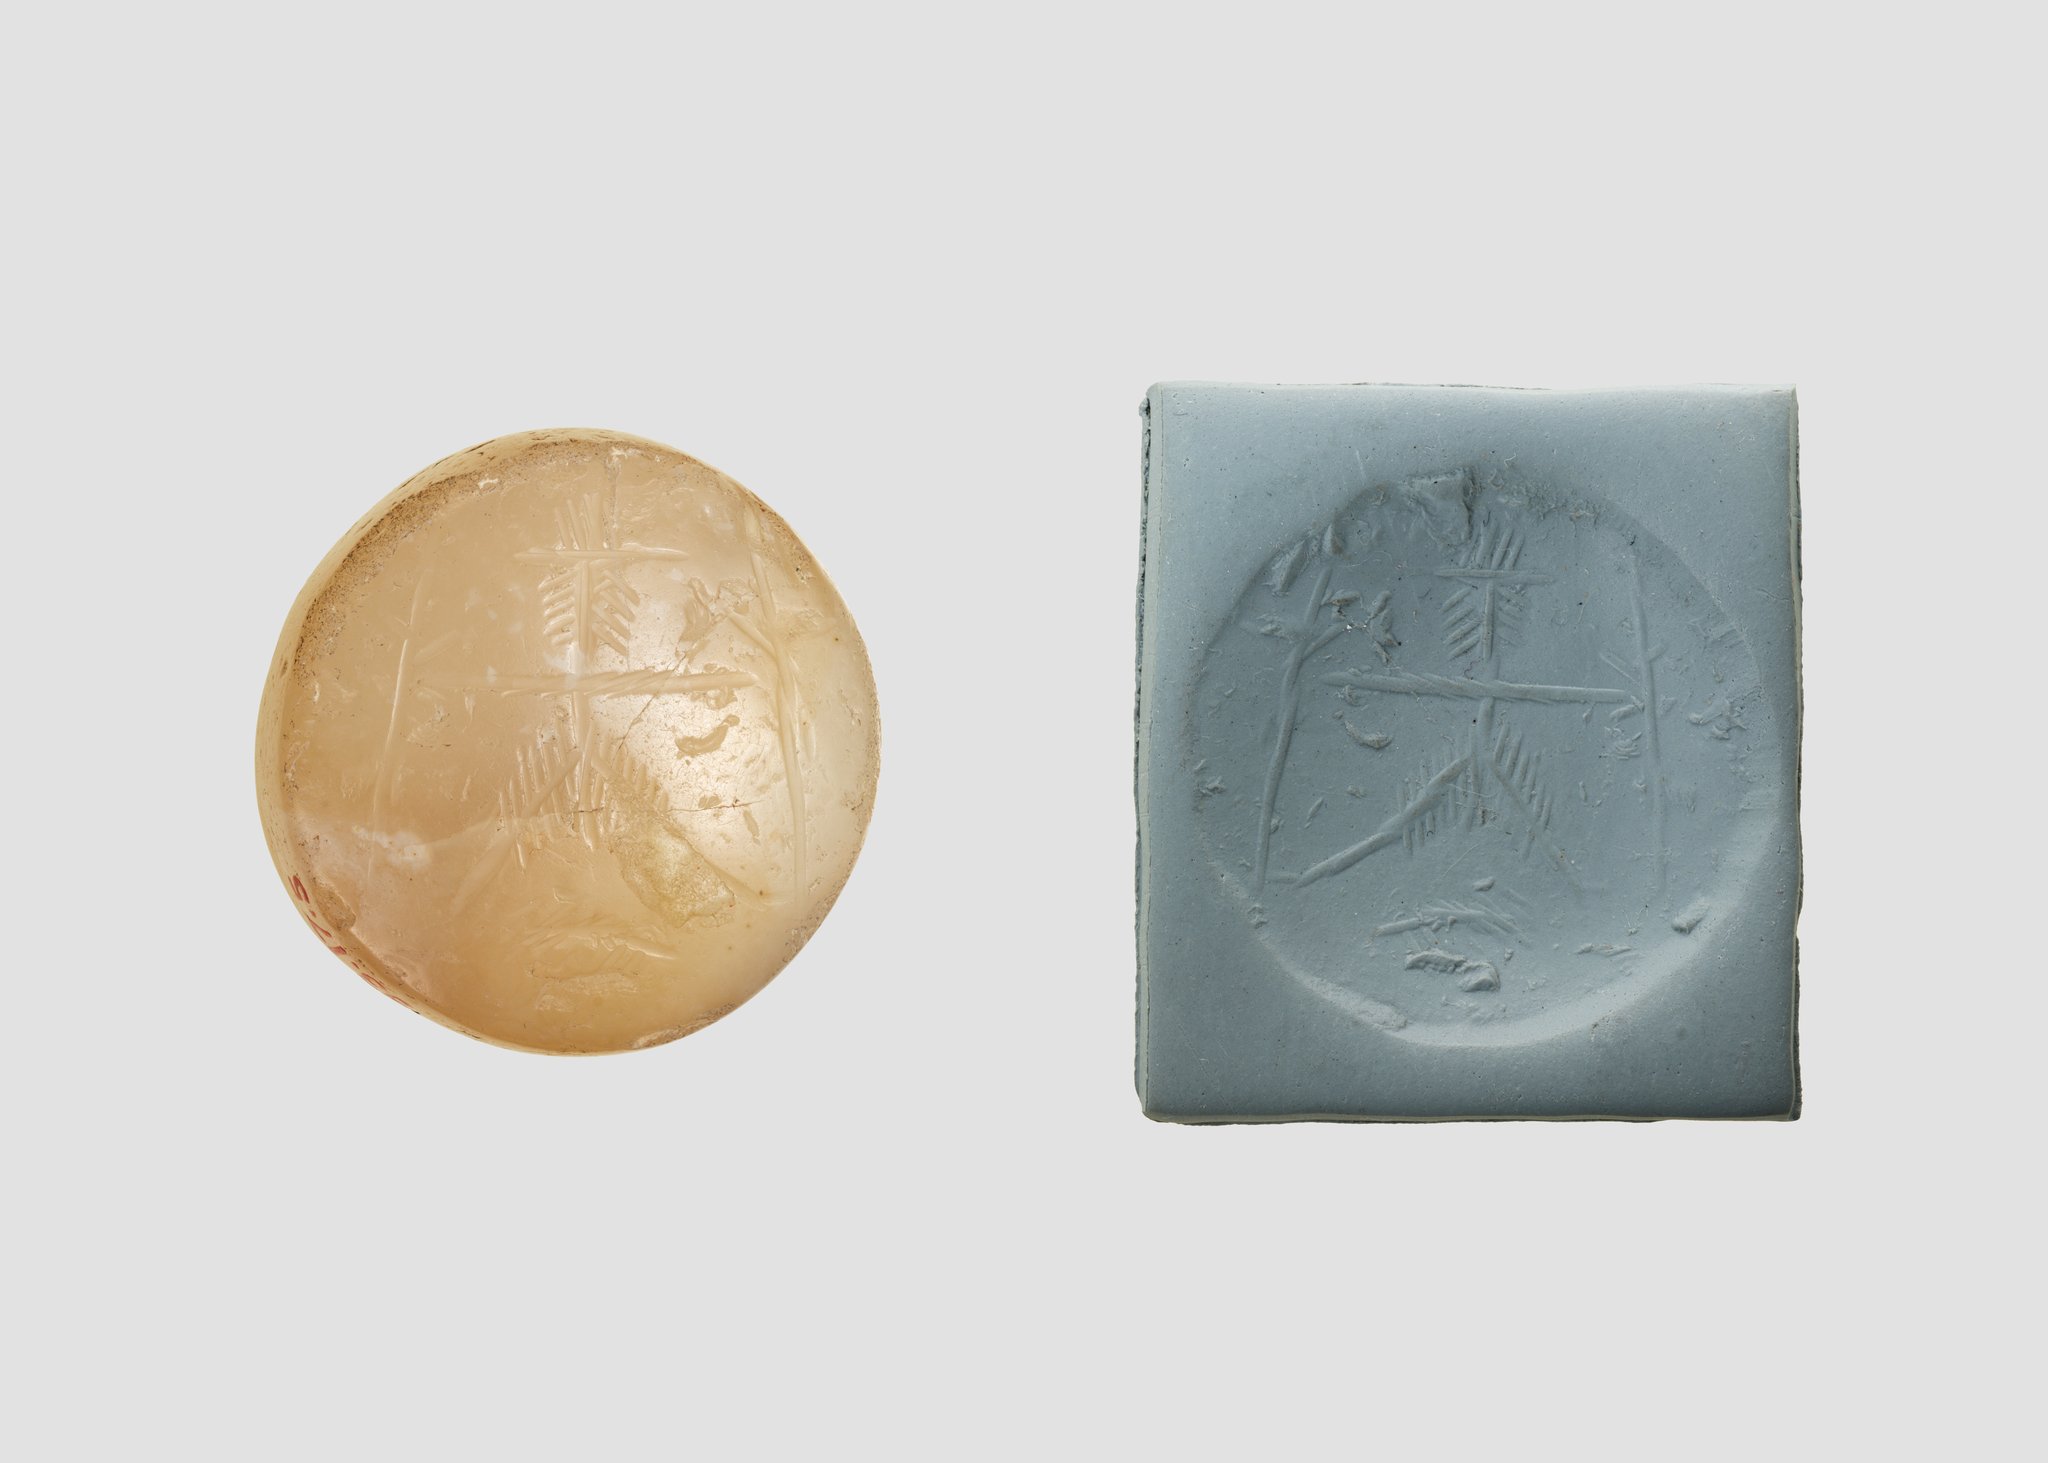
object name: stamp seal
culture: sasanian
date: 201-700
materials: stone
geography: iran or mesopotamia